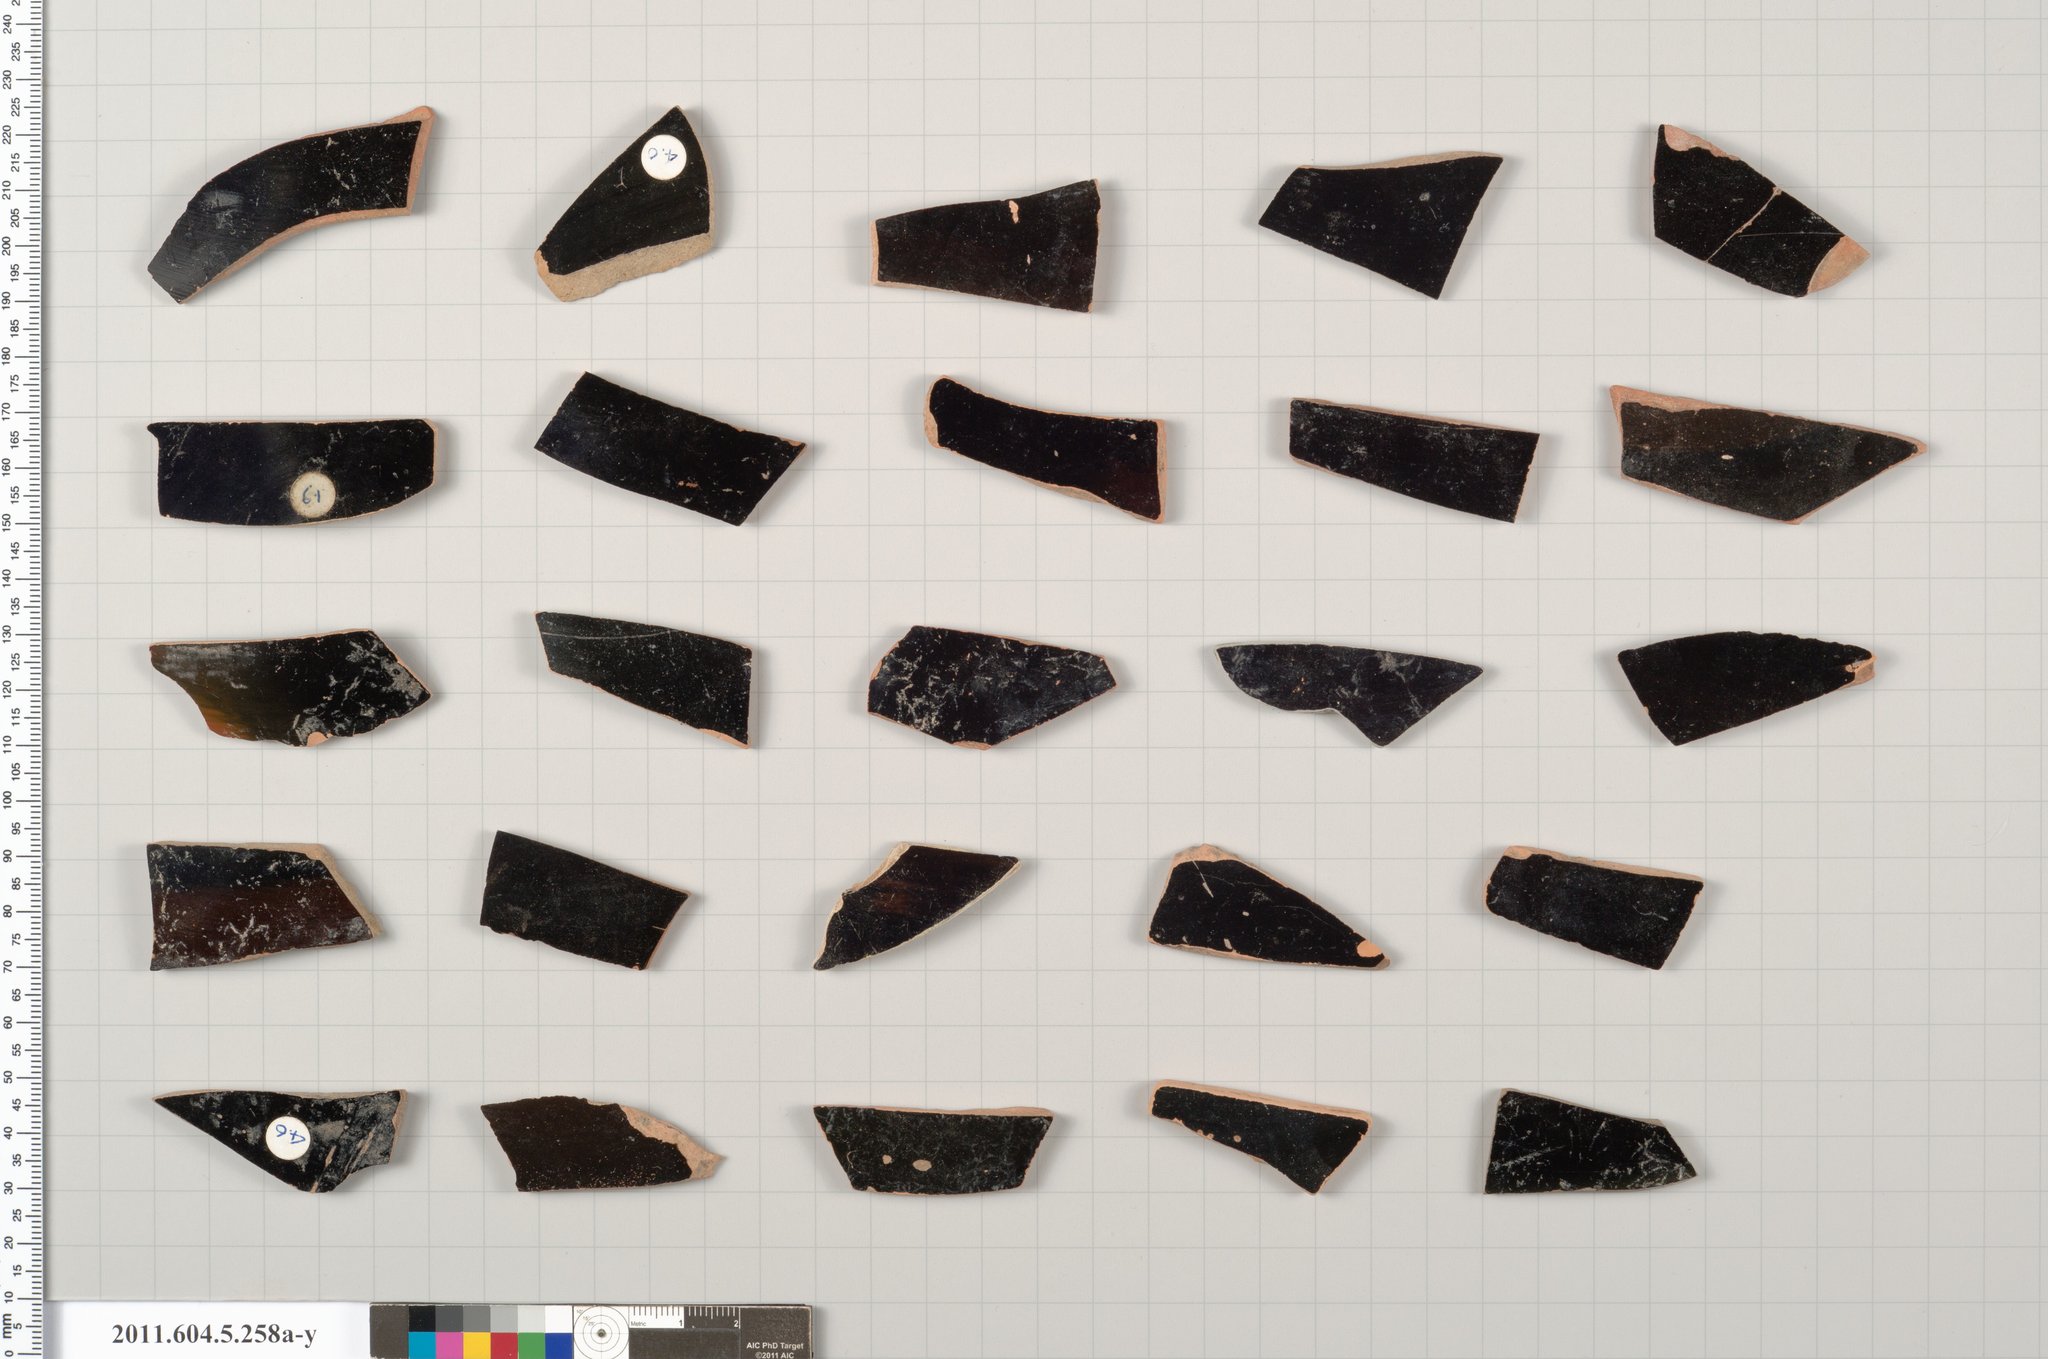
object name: kylix fragment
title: Terracotta fragments of kylikes (drinking cups)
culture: greek, attic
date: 600-401 BCE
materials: terracotta